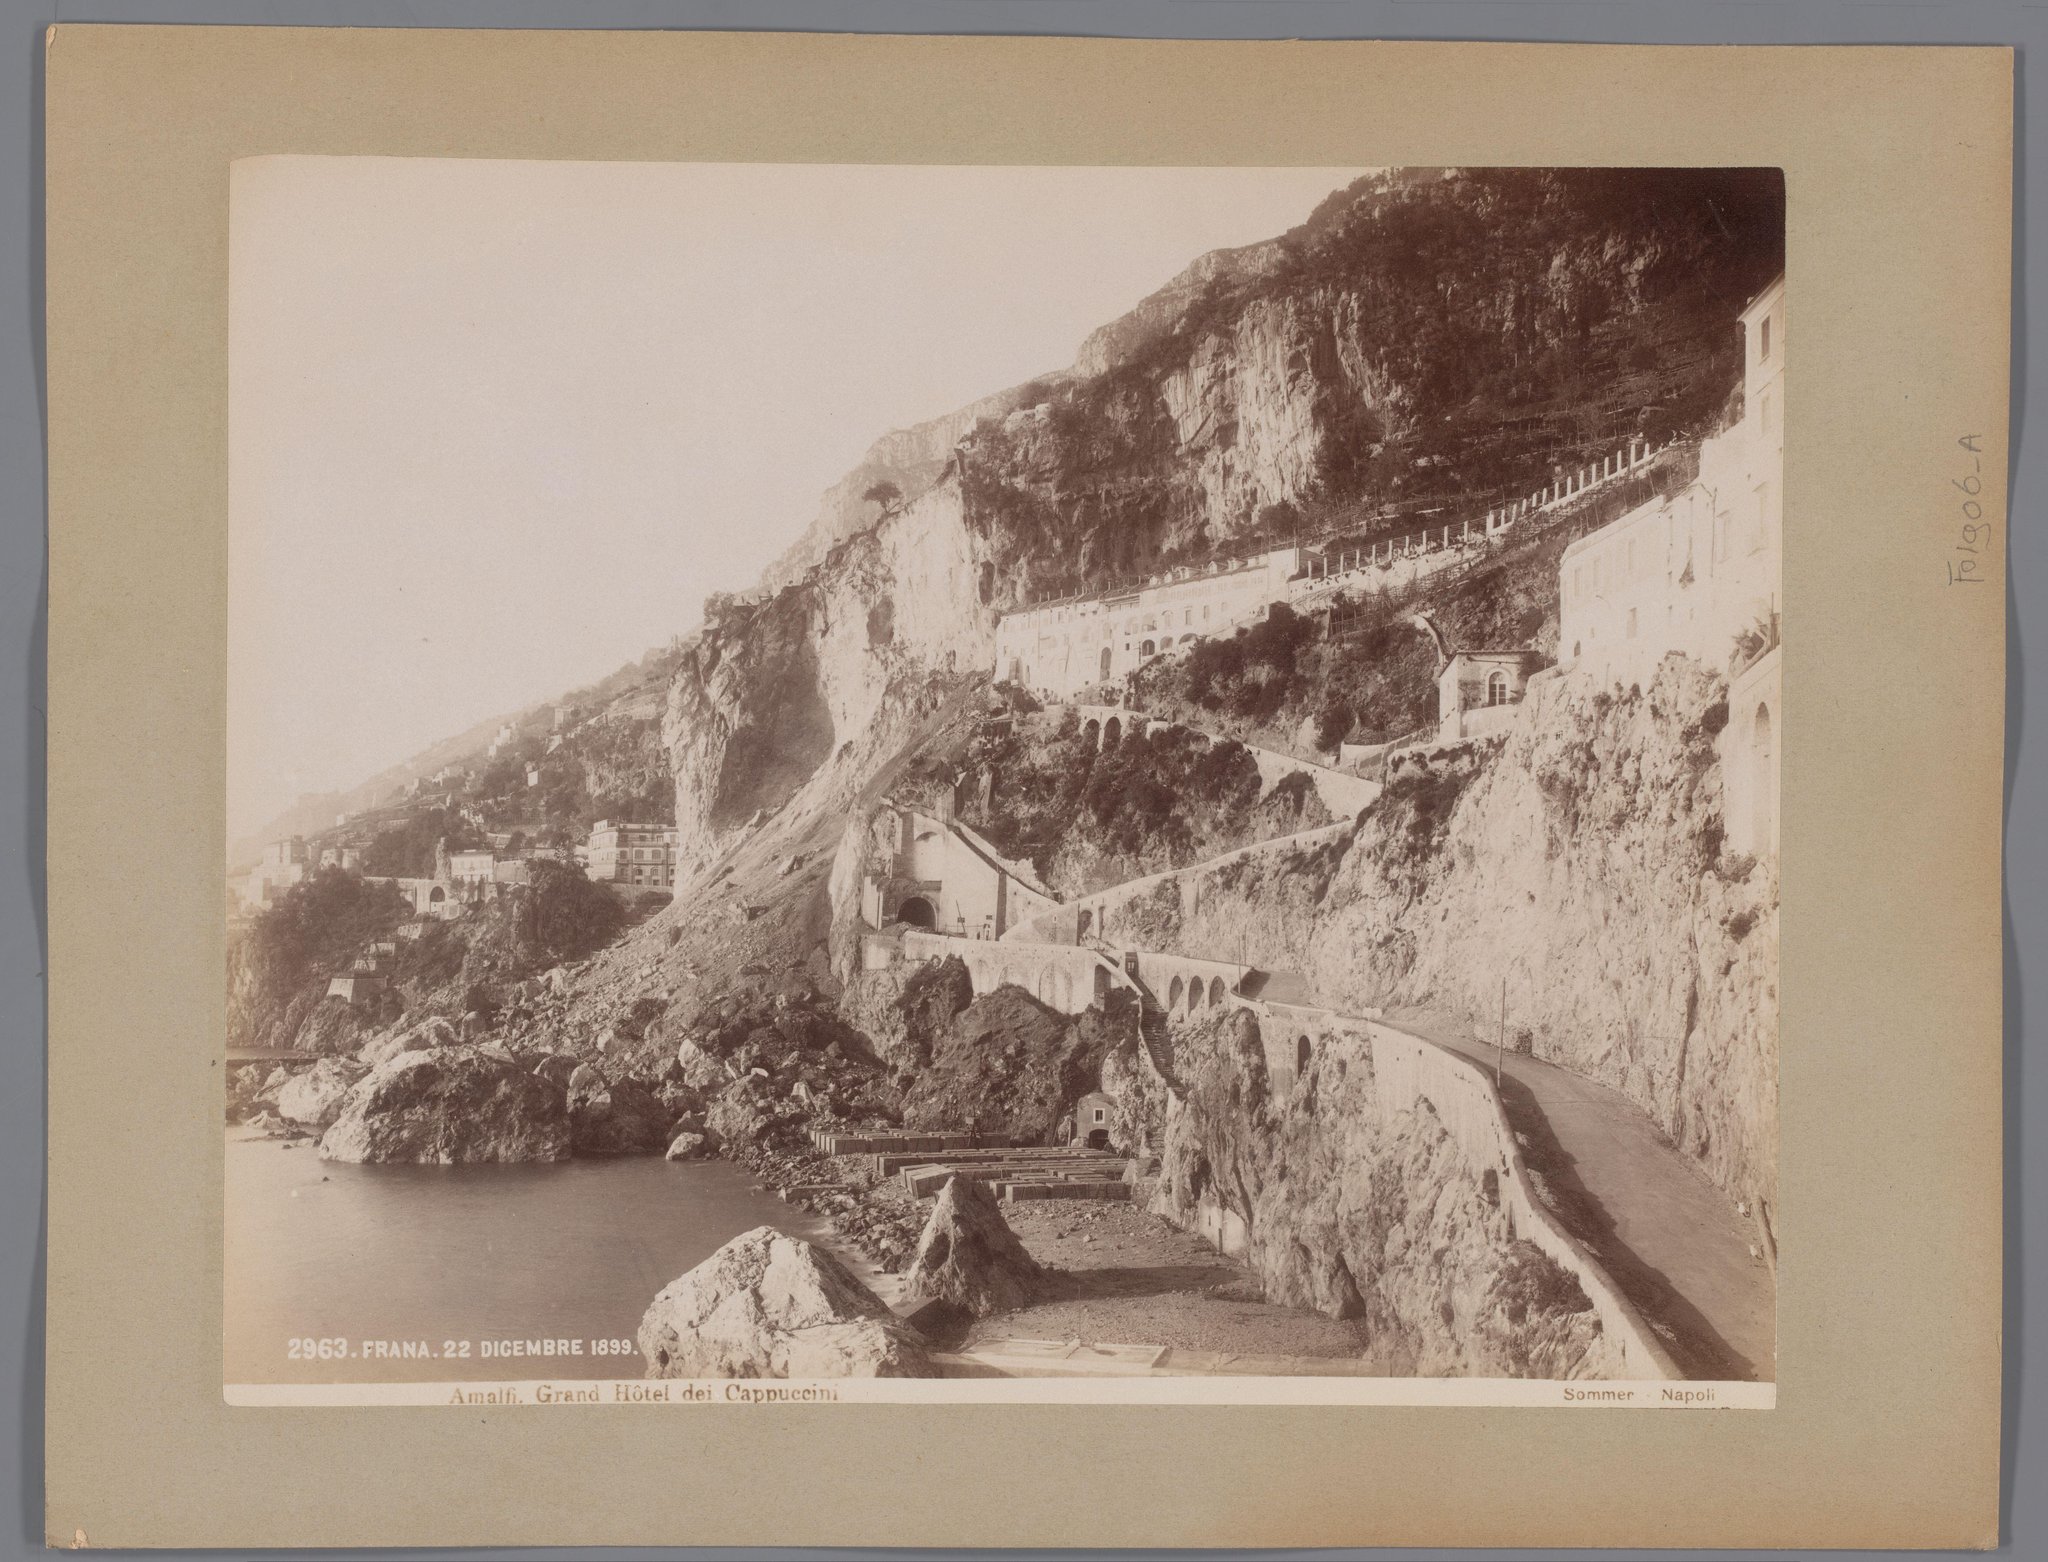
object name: photograph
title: Amalfi. Grand Hotel dei Cappuccini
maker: giorgio sommer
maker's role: fotograaf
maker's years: 1834-1914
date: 1899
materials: cardboard, paper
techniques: albumen print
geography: amalfi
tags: rocky coast, abbey, monastery, convent ~ roman catholic church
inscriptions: date: ‘FRANA. 22 DICEMBRE 1899.’, number: ‘2963.’